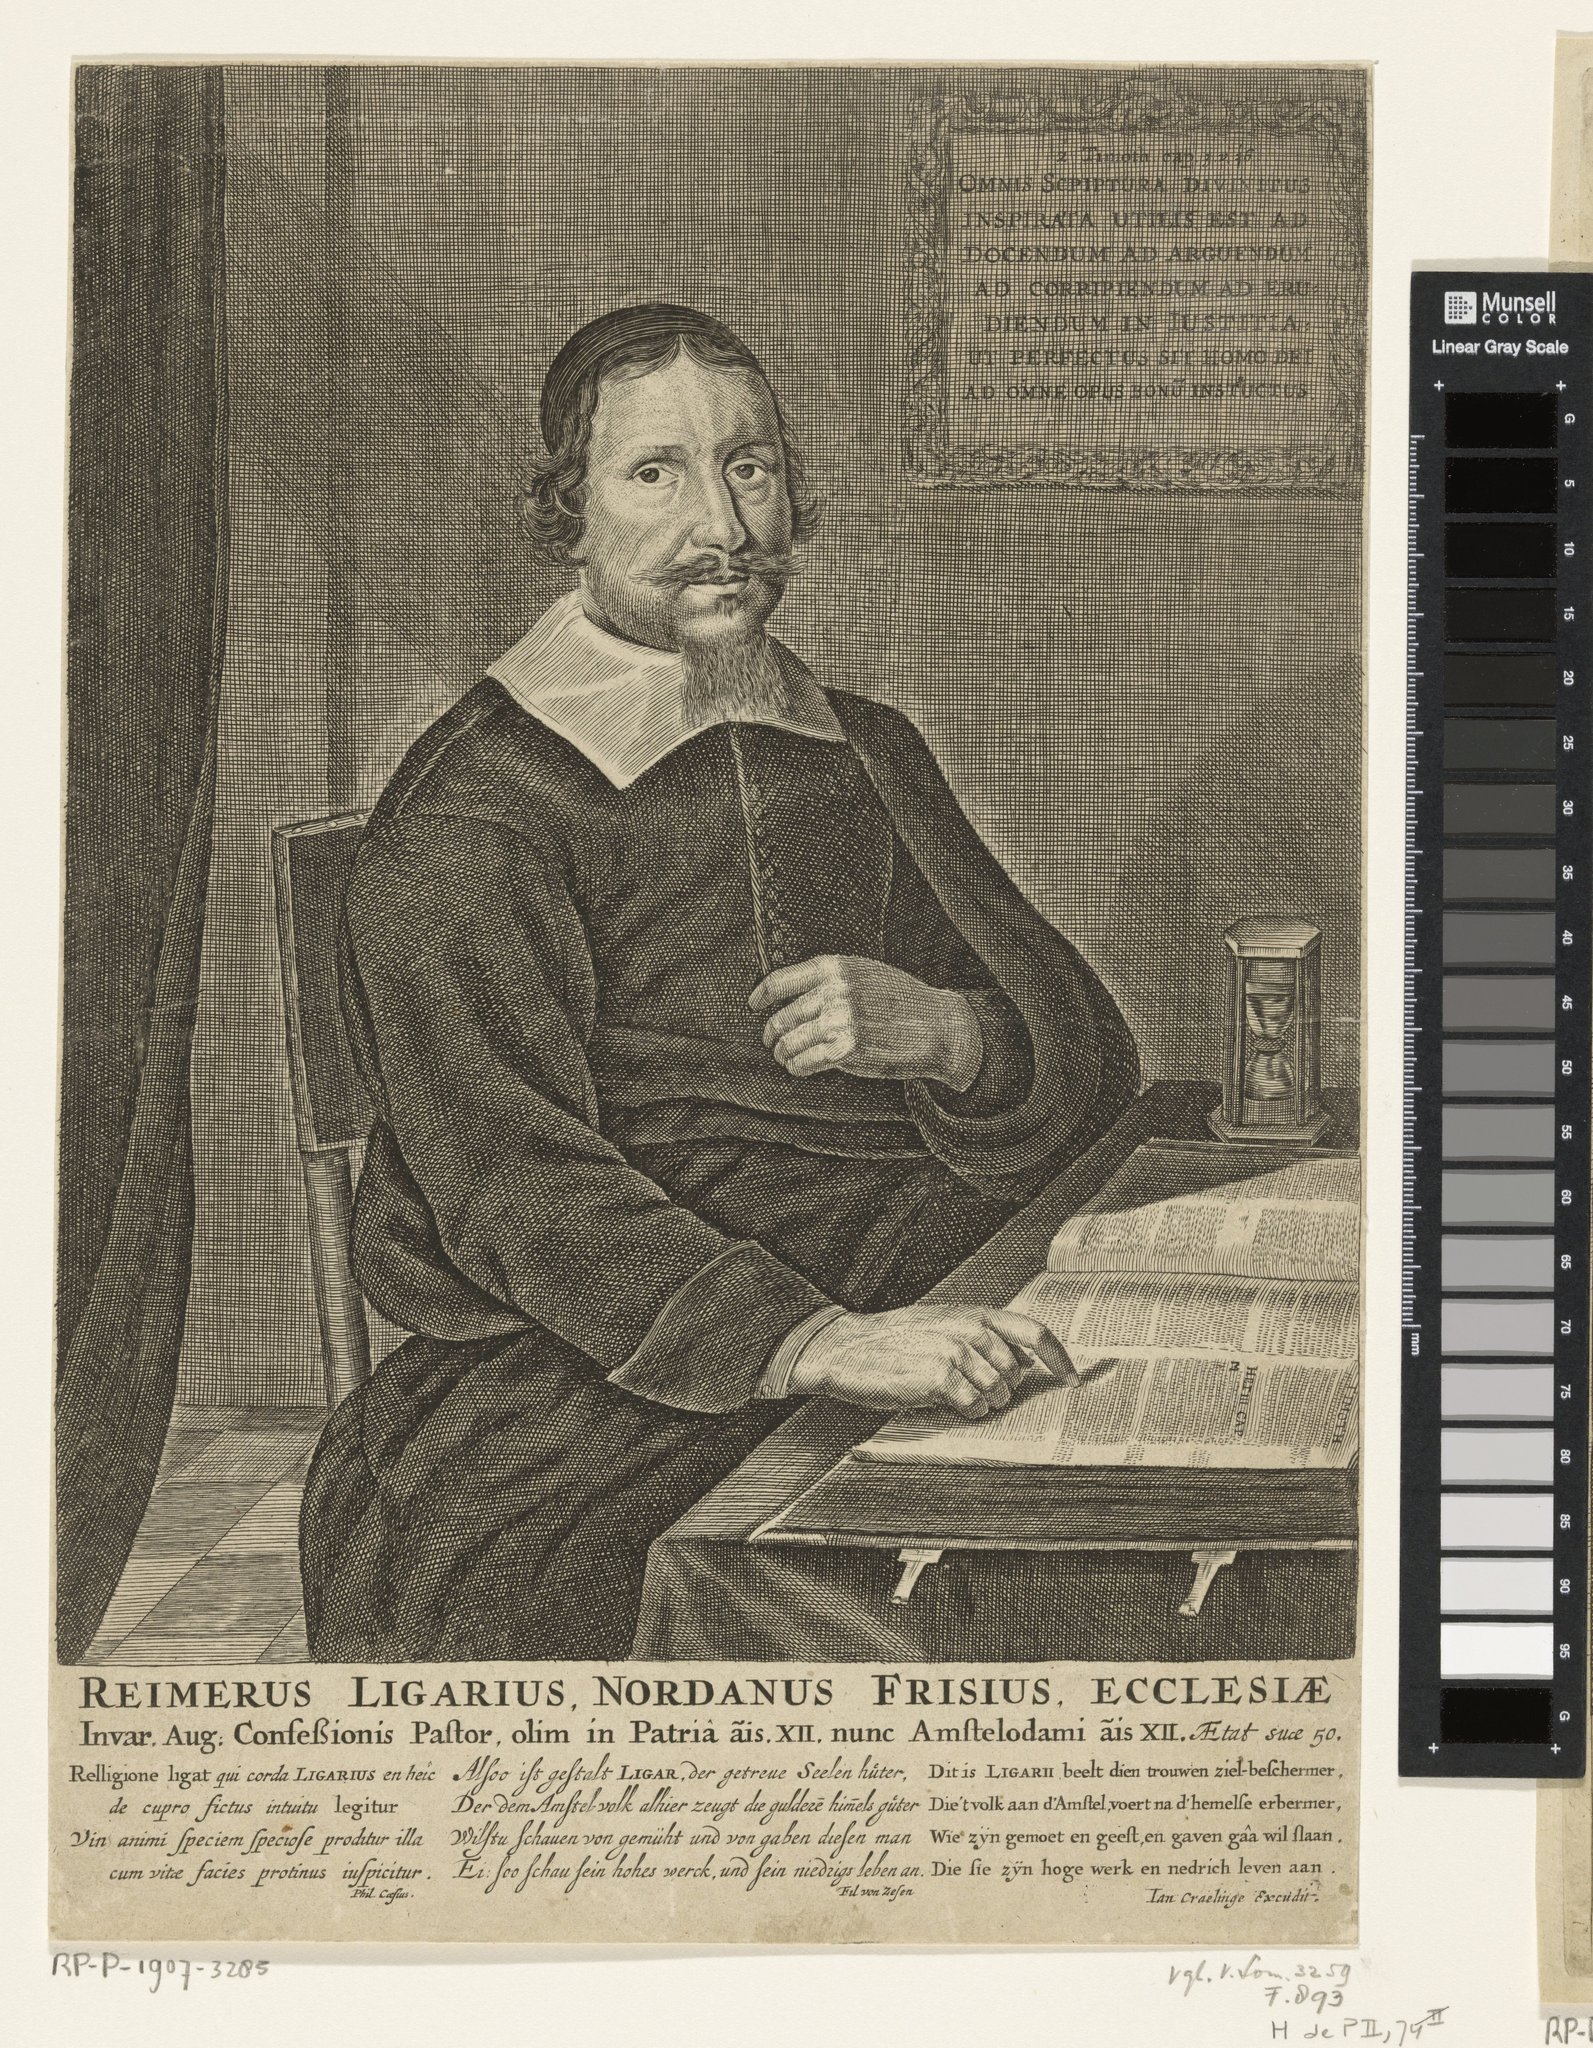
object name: print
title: Portret van Reimerus Ligarius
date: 1655-1673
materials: paper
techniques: engraving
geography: amsterdam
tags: amsterdam, reading the bible or other religious books, hourglass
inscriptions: collector's mark: Lugt 2228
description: Portret van Reimerus Ligarius, Luthers predikant te Amsterdam, op 50-jarige leeftijd. Op zijn schrijftafel ligt een opengeslagen bijbel en staat een zandloper. Rechtsboven een Bijbelcitaat uit 2 Tim. 3:16, in het Latijn. In de marge een vierregelig lofdicht in het Latijn, in het Duits en in het Nederlands. Kopie naar de gelijknamige prent van Crispijn van de Passe (II).